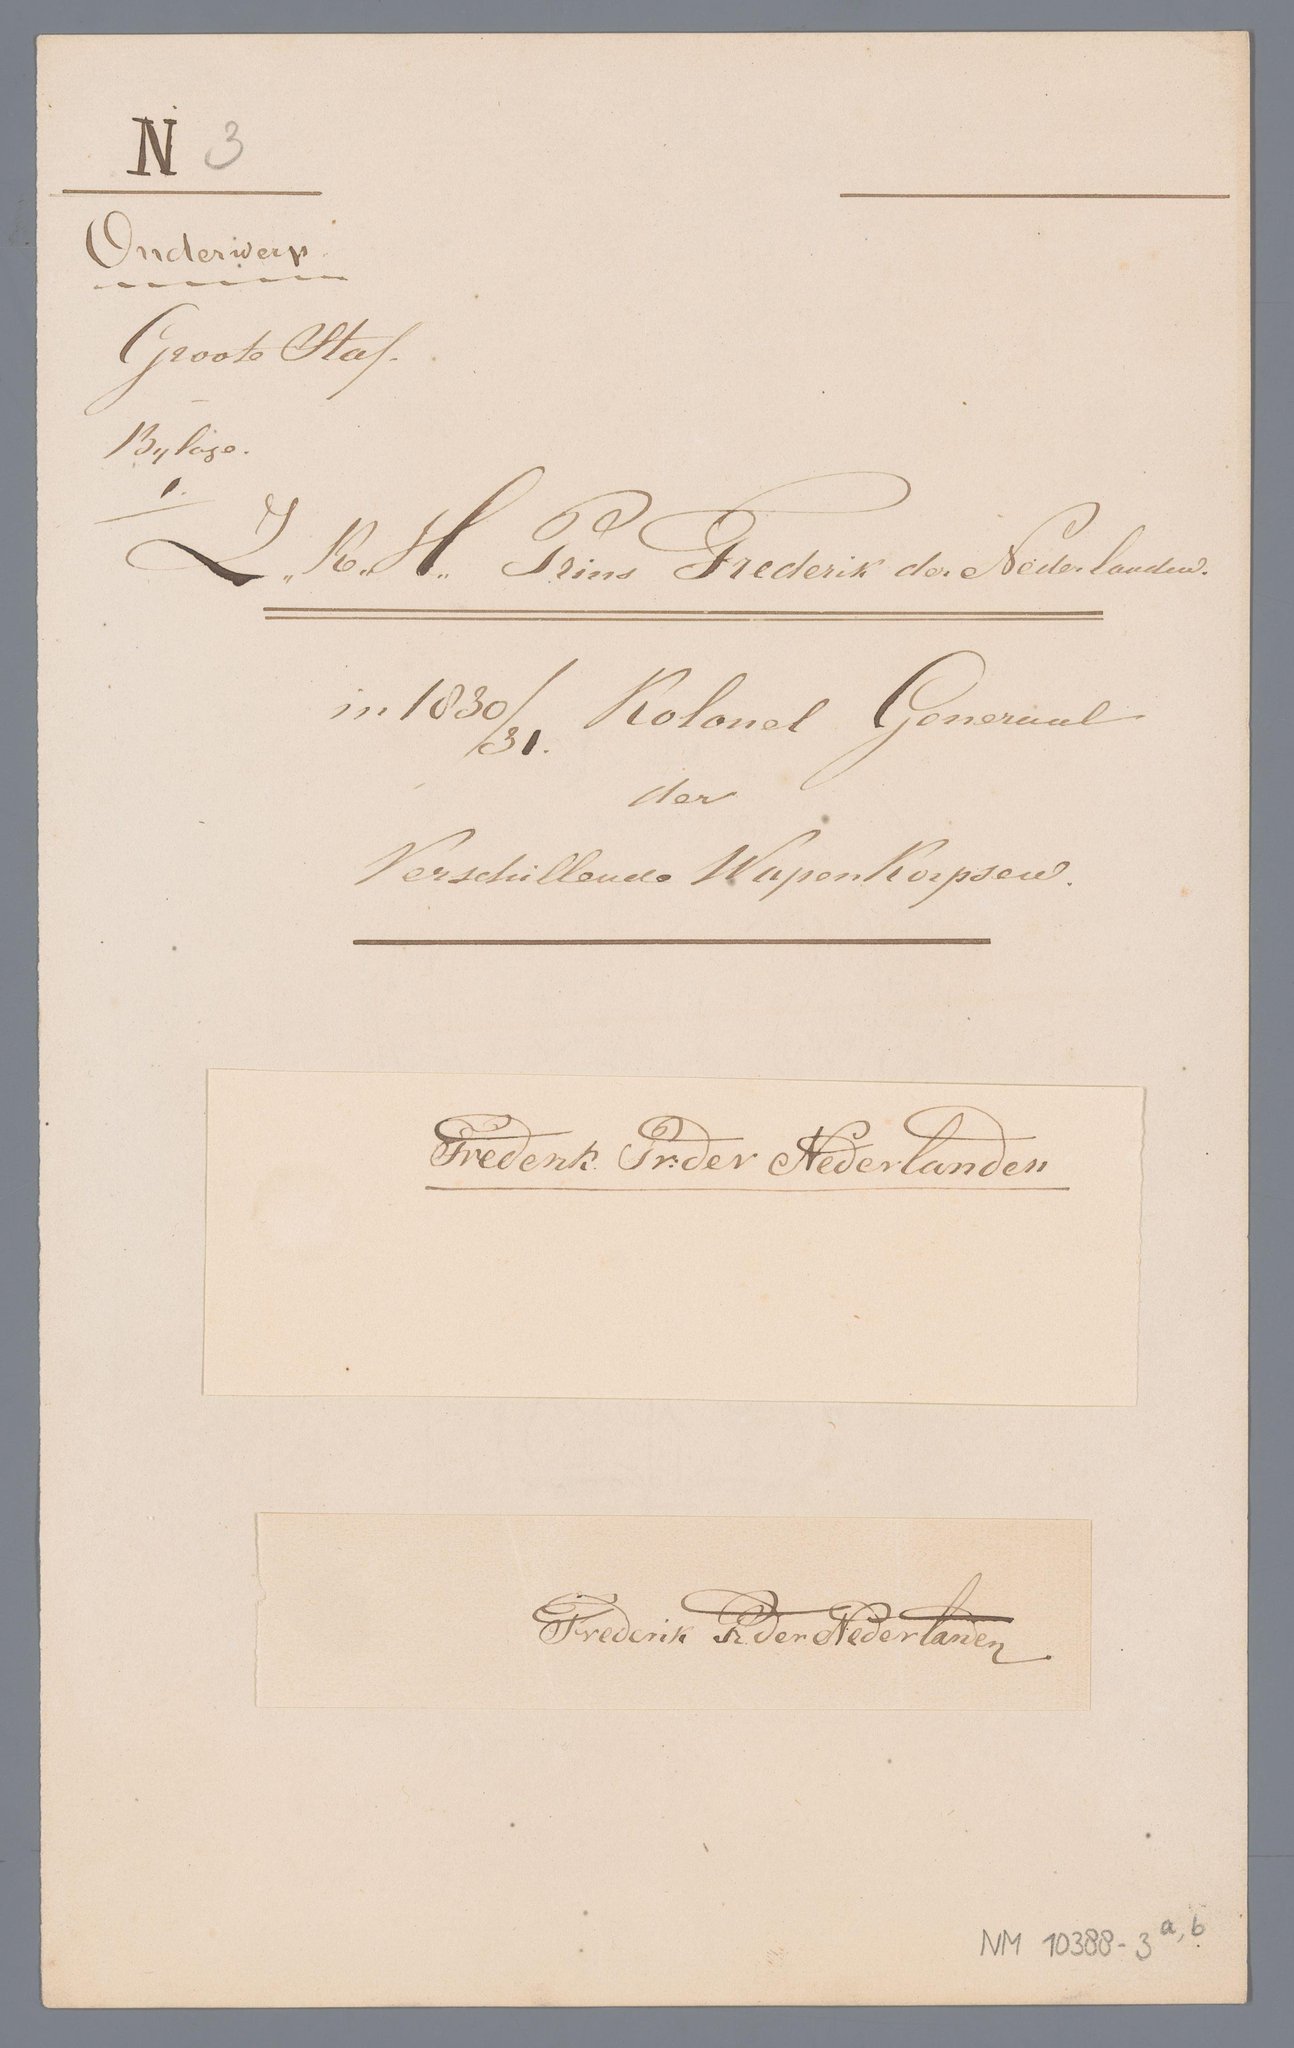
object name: sheet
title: Handtekeningen prins Frederik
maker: frederik (prins der nederlanden)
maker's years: 1797-1881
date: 1800-1850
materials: ink, paper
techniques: writing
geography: netherlands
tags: berlin, frederik (prins der nederlanden)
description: Blad papier, aan de voorzijde 2 handtekeningen opgeplakt. Opschrift; b.: 'ZKH Prins Frederik de Nederlanden / is 1830 - 31 Kolonel Generaal de verschillende wapenkorpsen'.